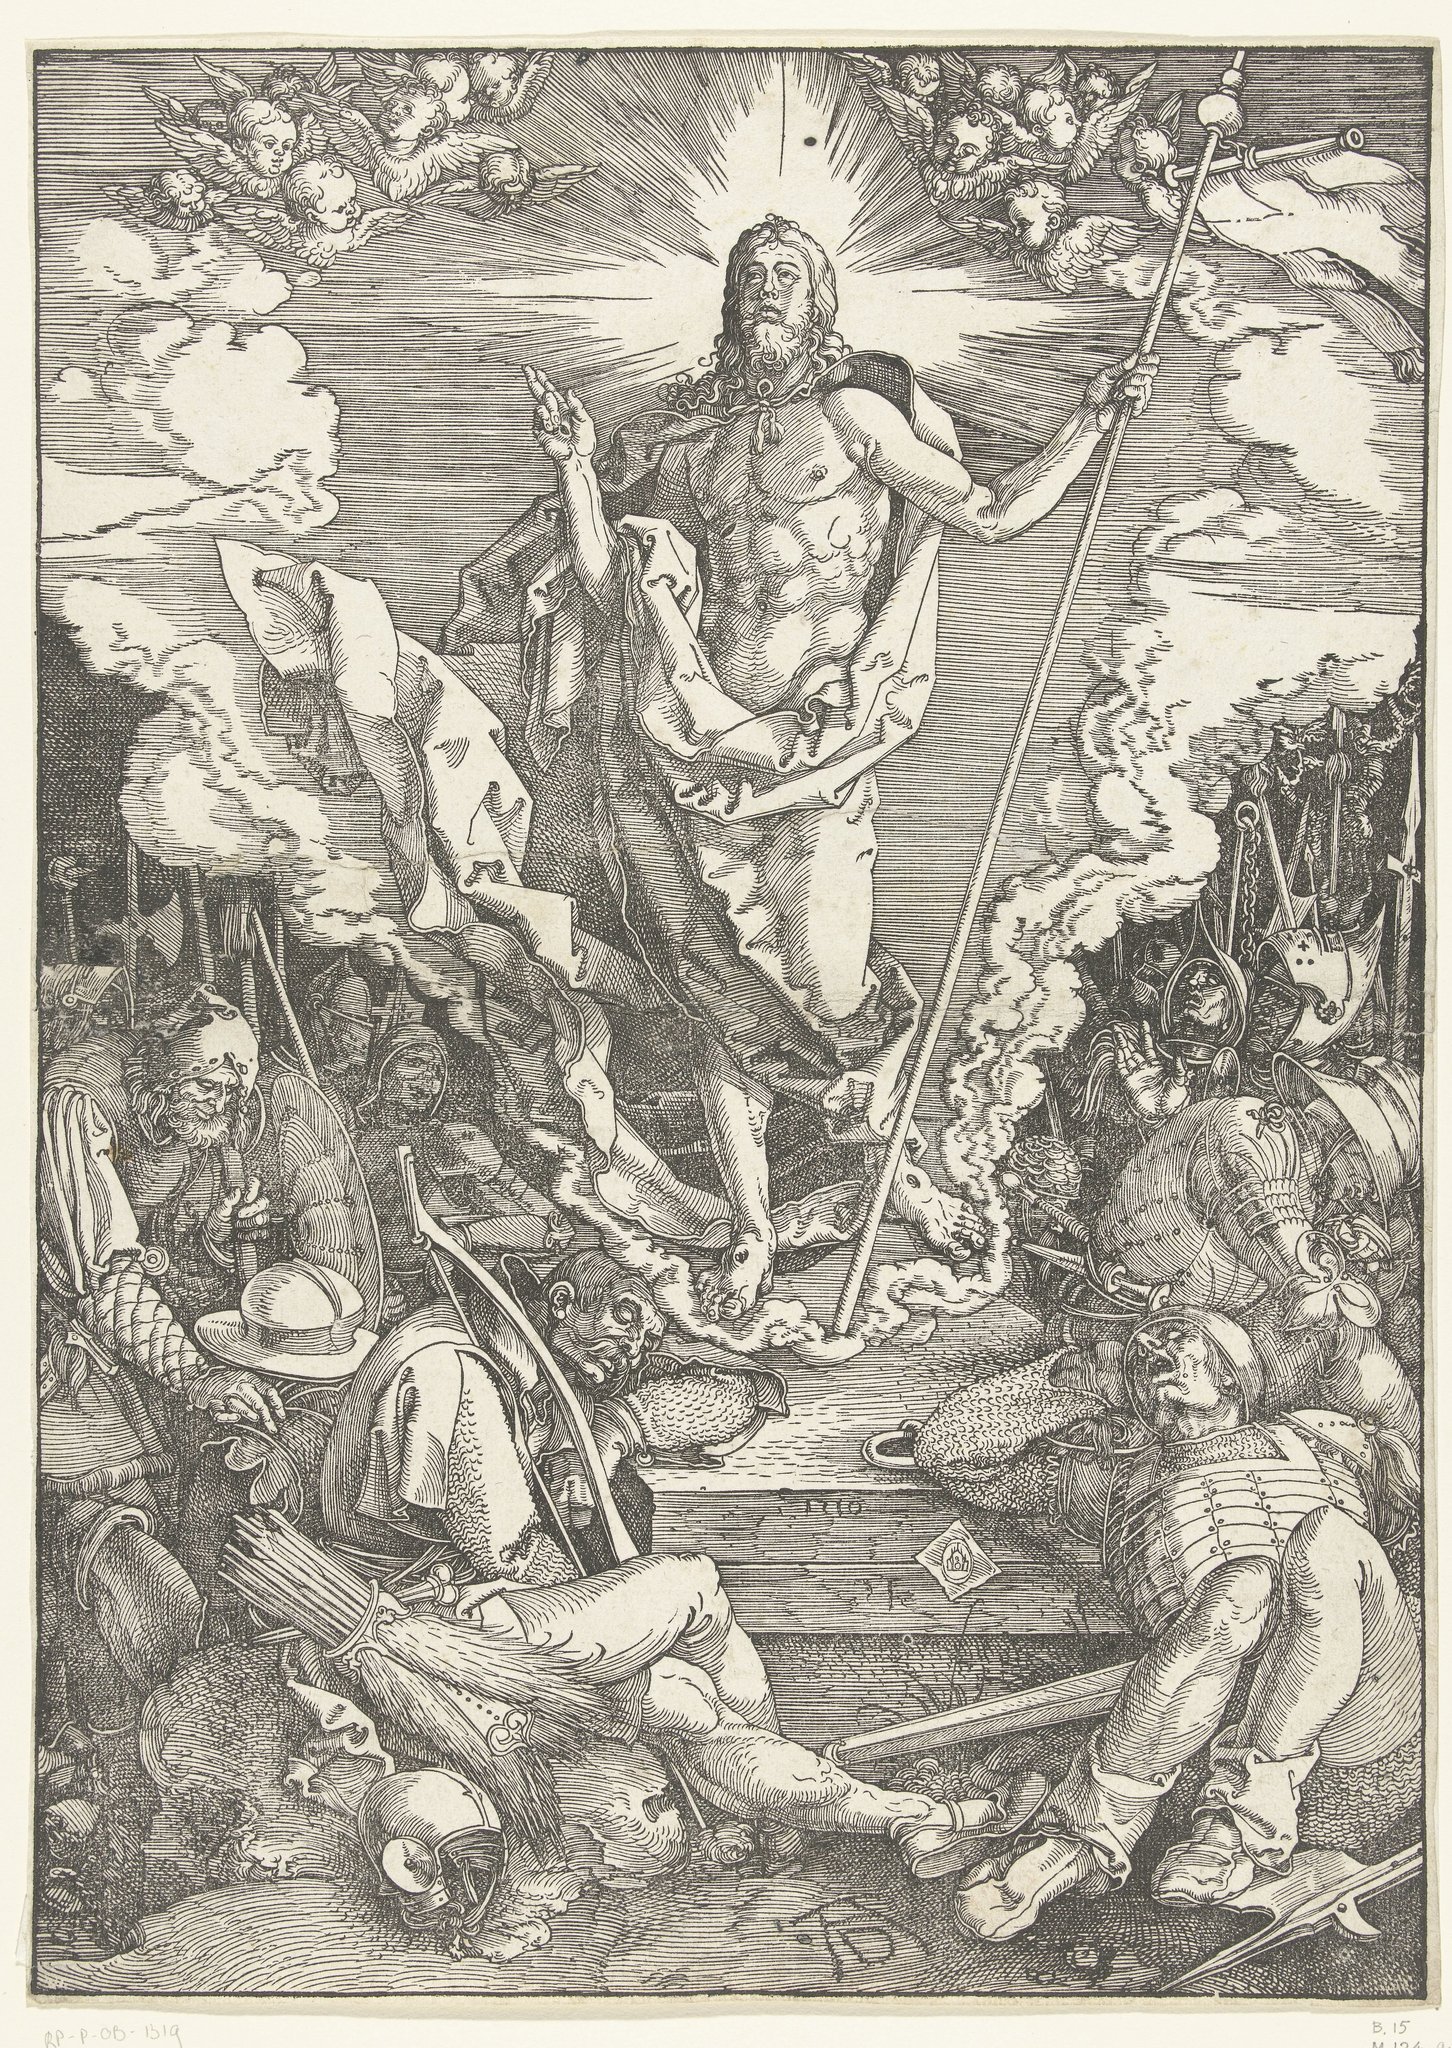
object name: print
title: De grote Passie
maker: albrecht dürer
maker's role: draughtsman, painter, print maker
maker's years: 1471-1528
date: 1510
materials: paper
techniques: woodcut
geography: nuremberg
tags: christ, usually holding a banner, arises from the grave; often combined with sleeping and/or frightened soldiers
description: Christus, een staf met een vaan in de hand, staat op uit zijn graf. Een aantal slapende soldaten zit eromheen. Deze prent is onderdeel van de prentserie 'De grote Passie', bestaande uit een titelprent en 11 scènes uit het Lijdensverhaal.